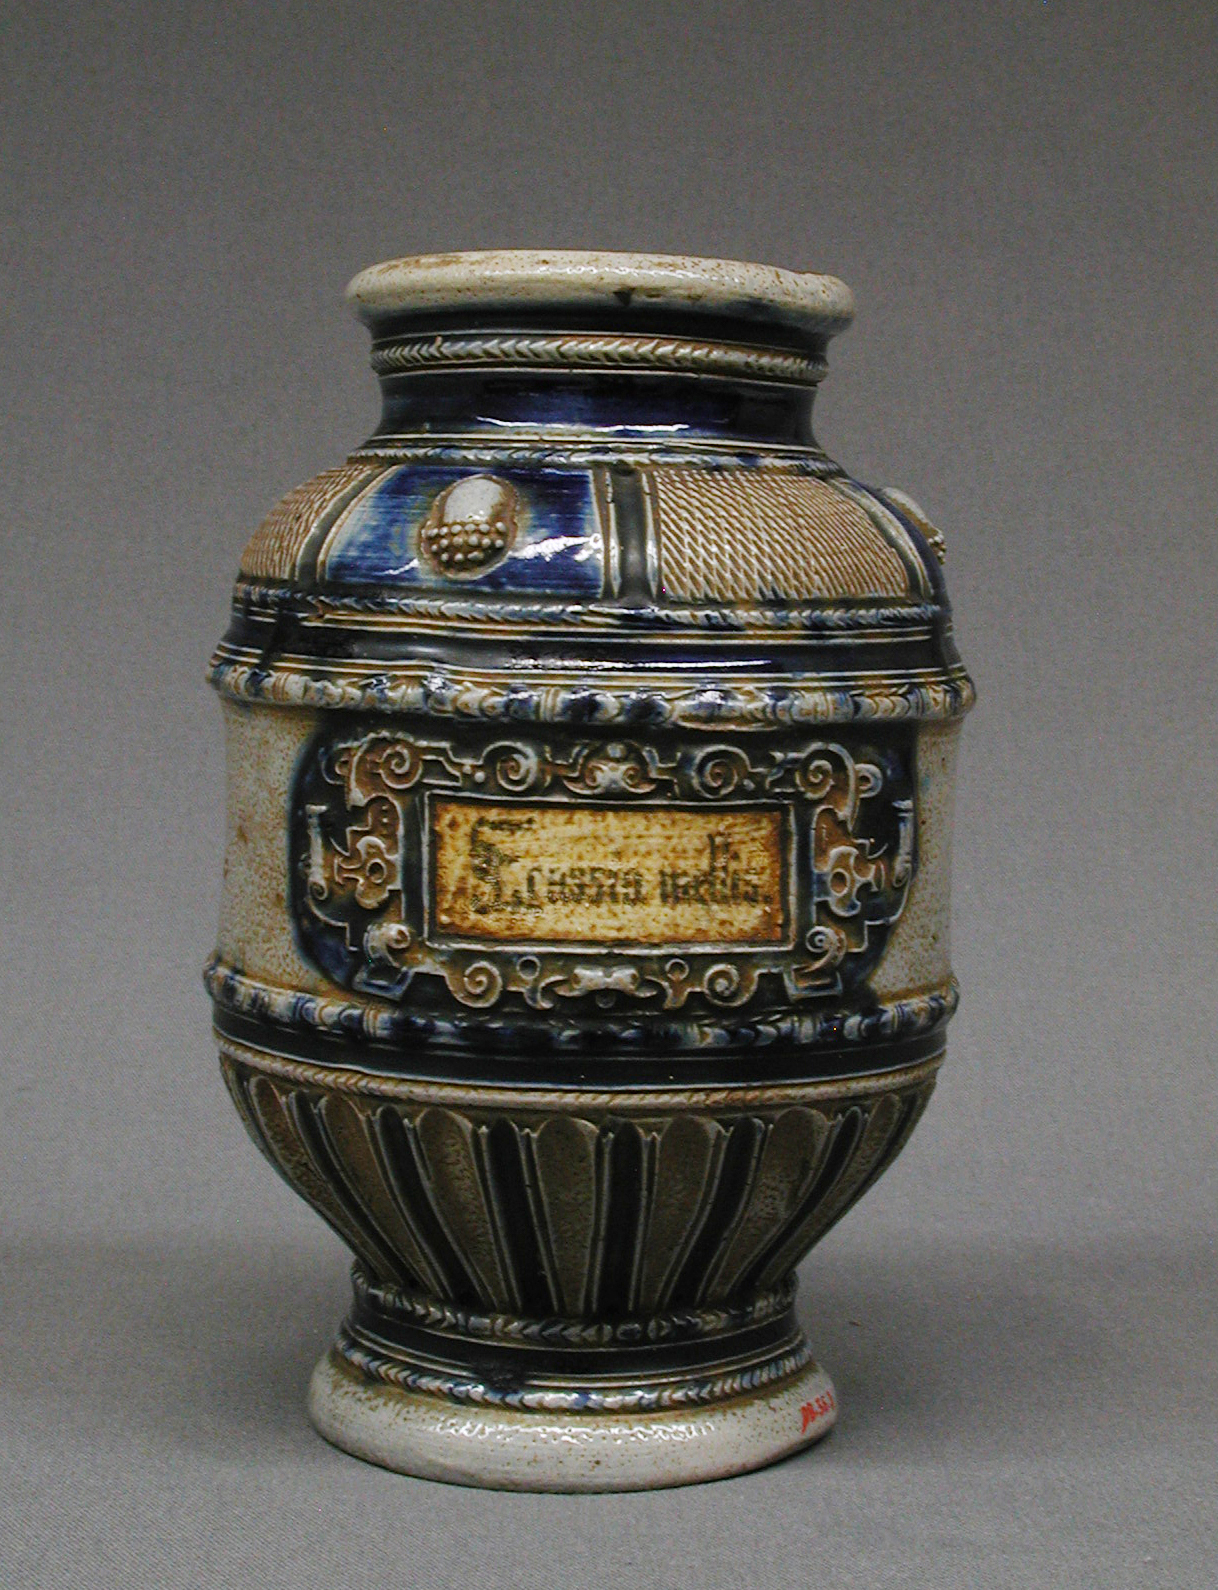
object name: pharmacy jar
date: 1867-1900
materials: stoneware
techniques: salt glaze